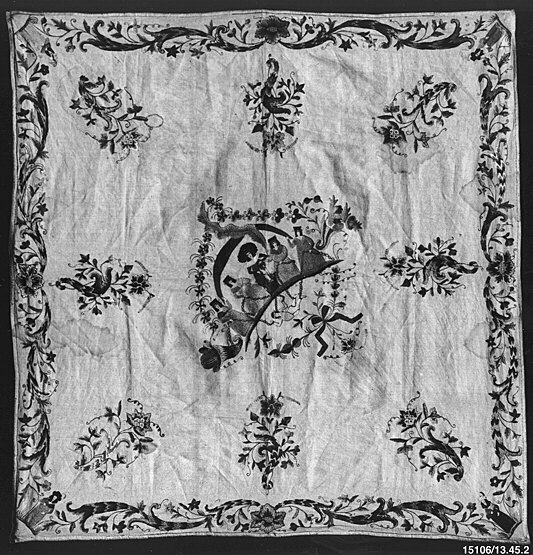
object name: cover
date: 1701-1800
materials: linen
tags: women,flowers